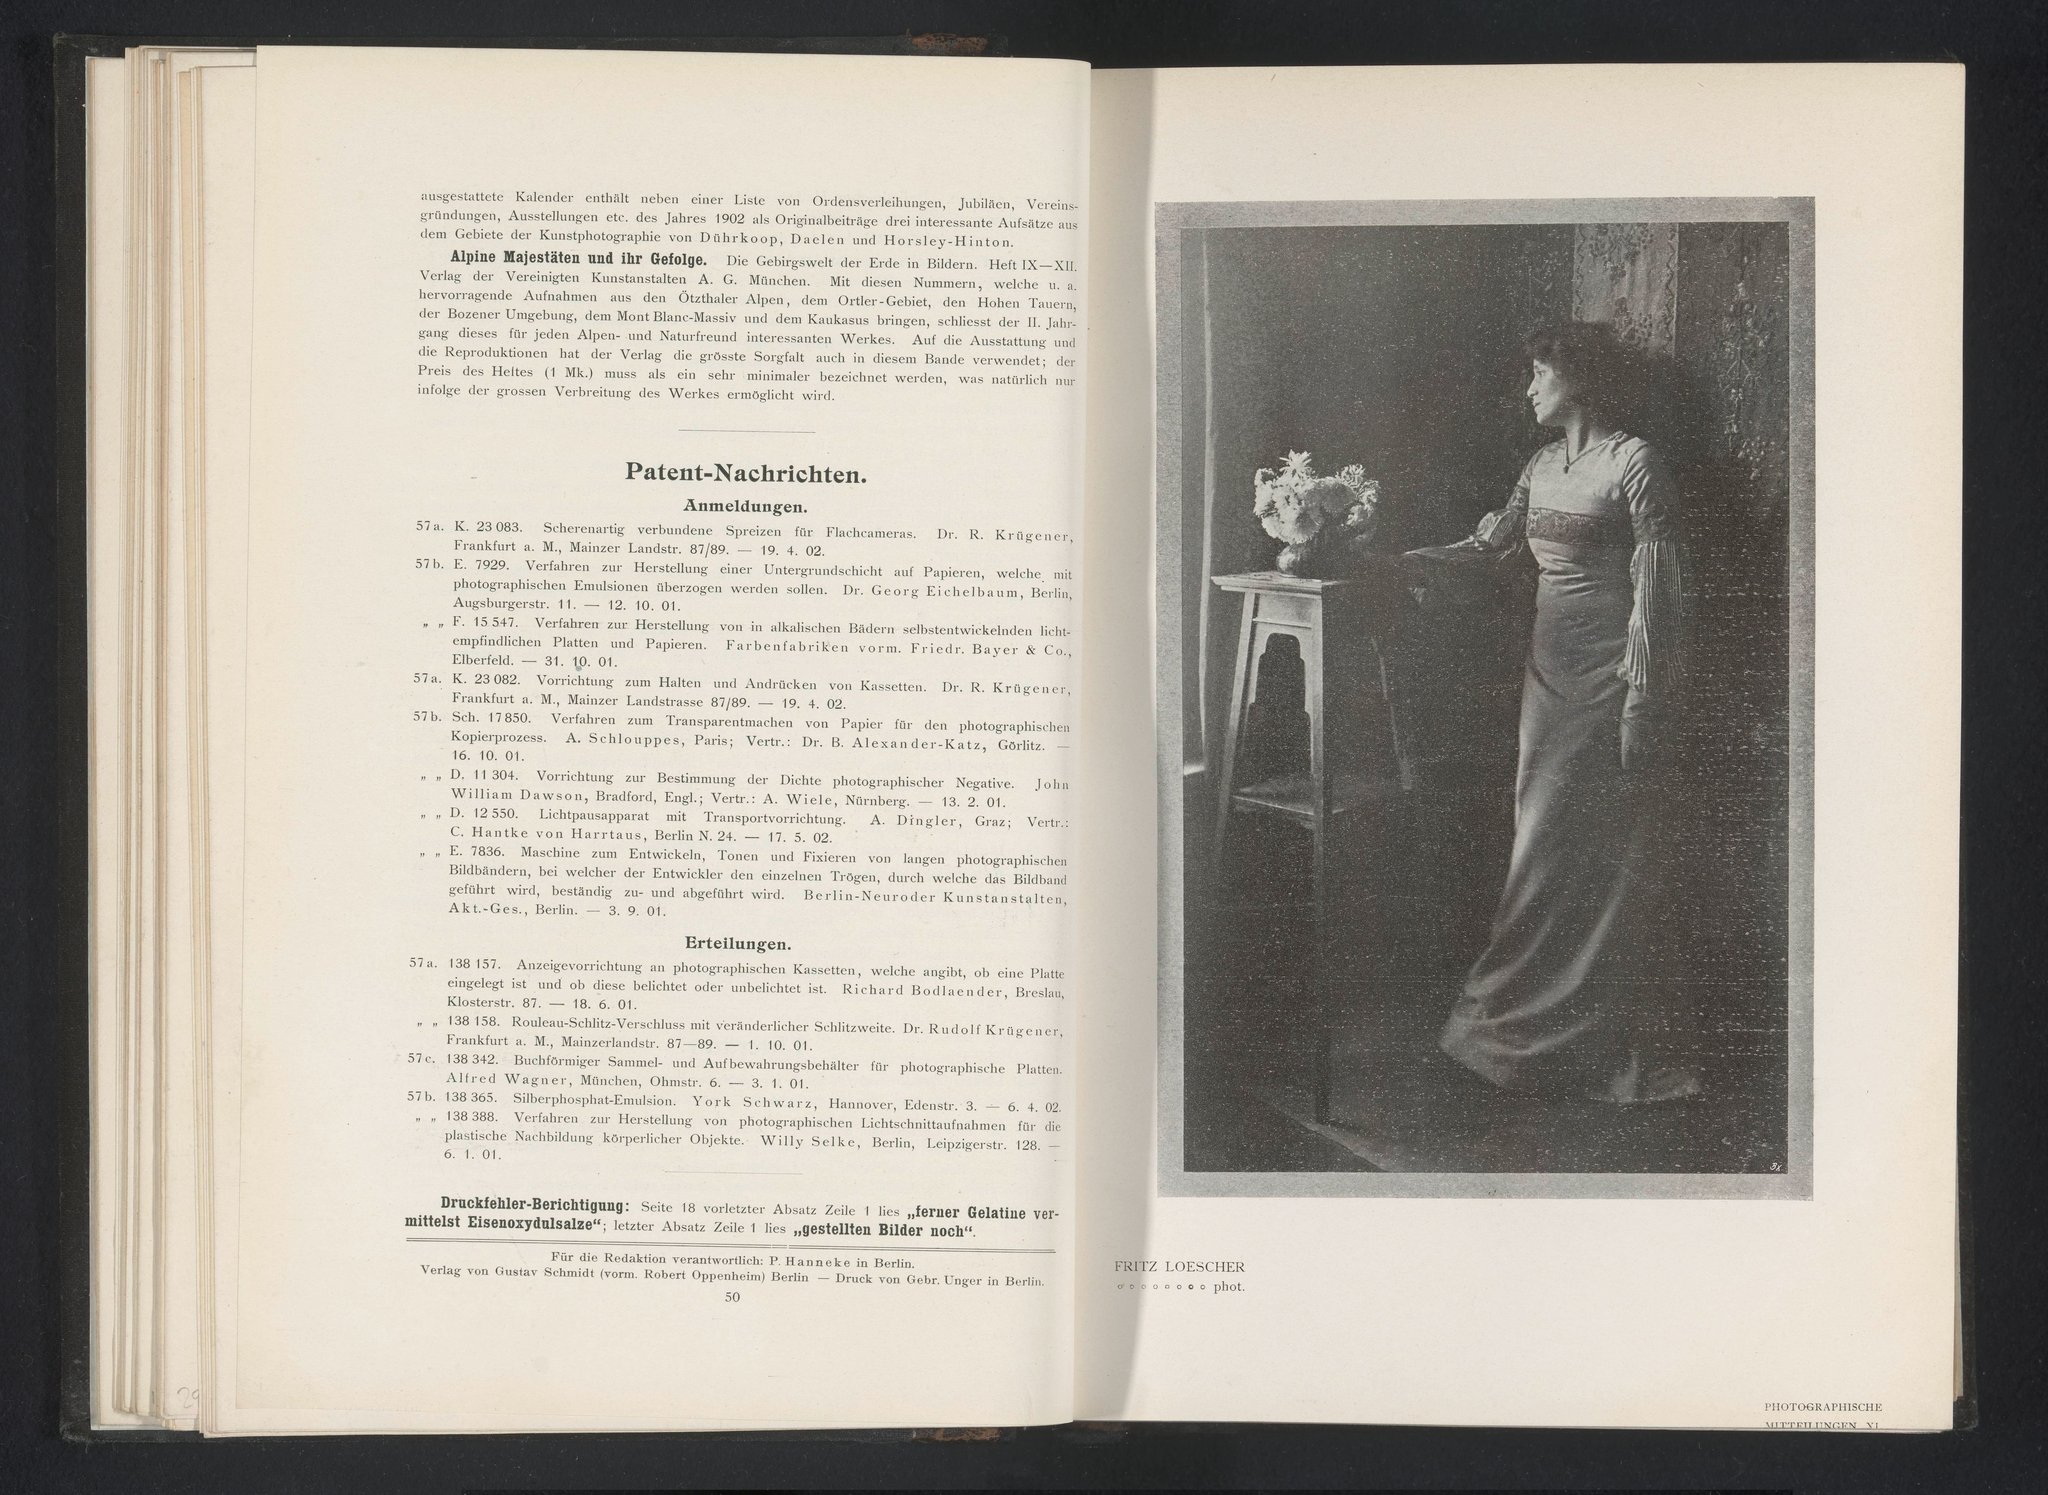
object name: photomechanical print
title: Portret van een onbekende vrouw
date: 1898-1903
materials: paper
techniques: autotype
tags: historical persons - bb - woman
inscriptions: inscription: ‘Photographische Mitteilungen XL’, monogram: ‘BX’